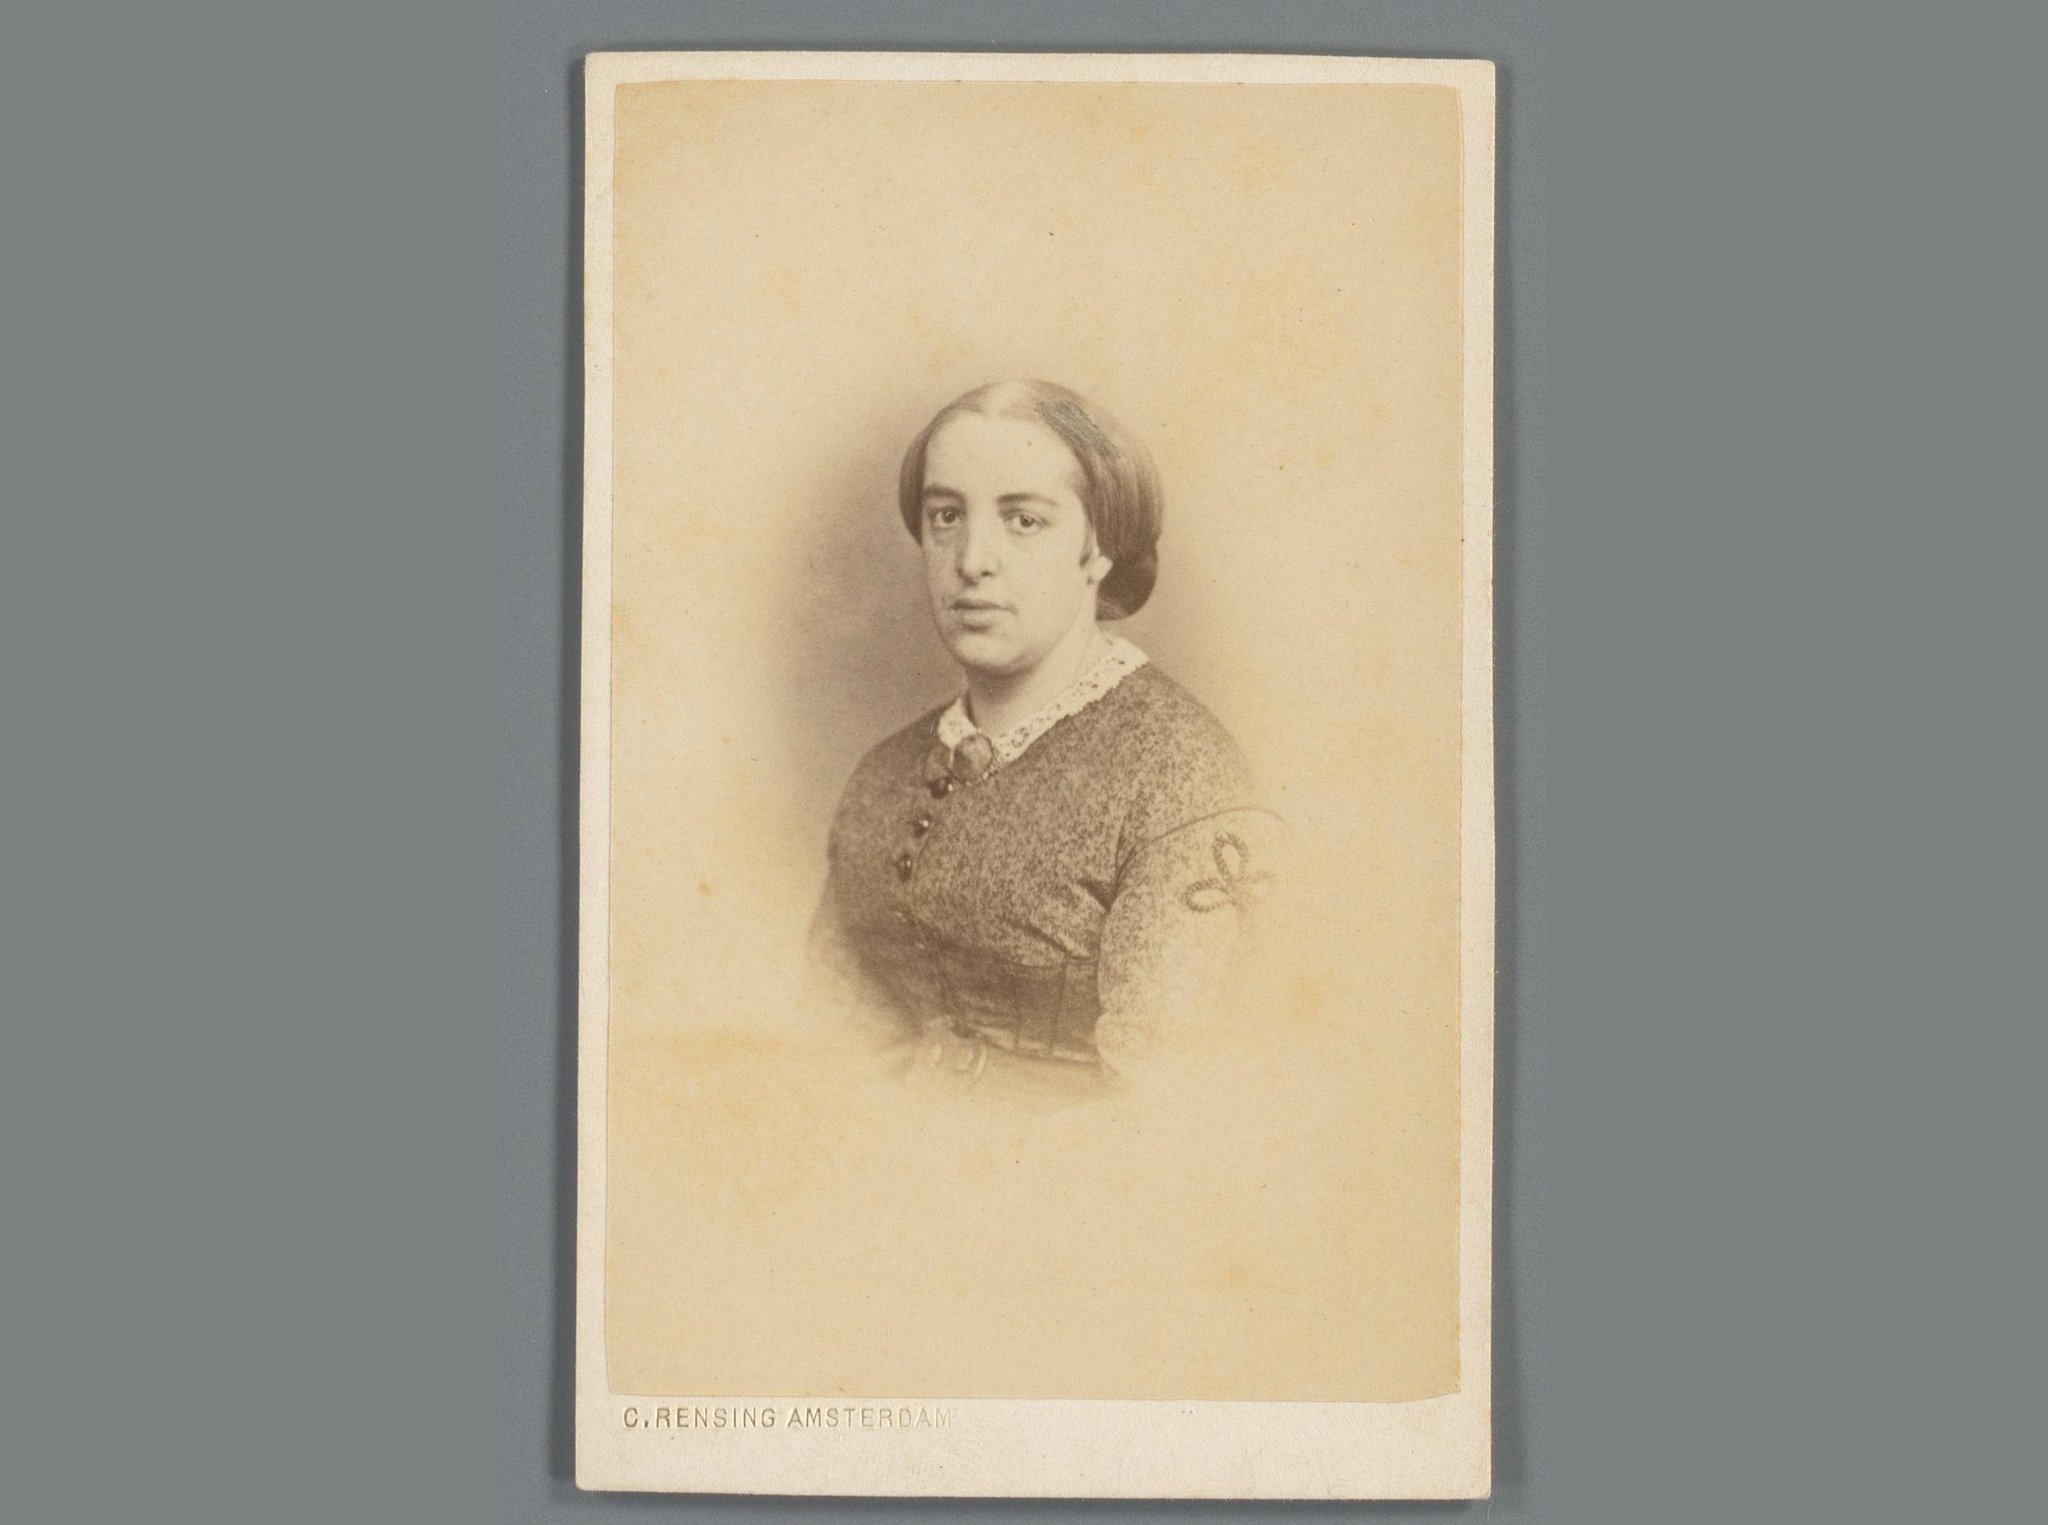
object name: photograph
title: Portret van een onbekende vrouw uit de familie en de kring van Eugene van Delden en Belle van Delden-Denninghof Stelling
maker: carl rensing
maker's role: fotograaf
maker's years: 1826-1898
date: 1872-1898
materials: cardboard, paper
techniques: albumen print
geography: amsterdam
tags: historical persons not known by name - bb - woman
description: Portret uit de kring van Eugene van Delden (Hartapoera, 1865 - Den Haag, 1954) en Belle van Delden-Denninghof Stelling (Batavia, 1870 - Den Haag, 1947).